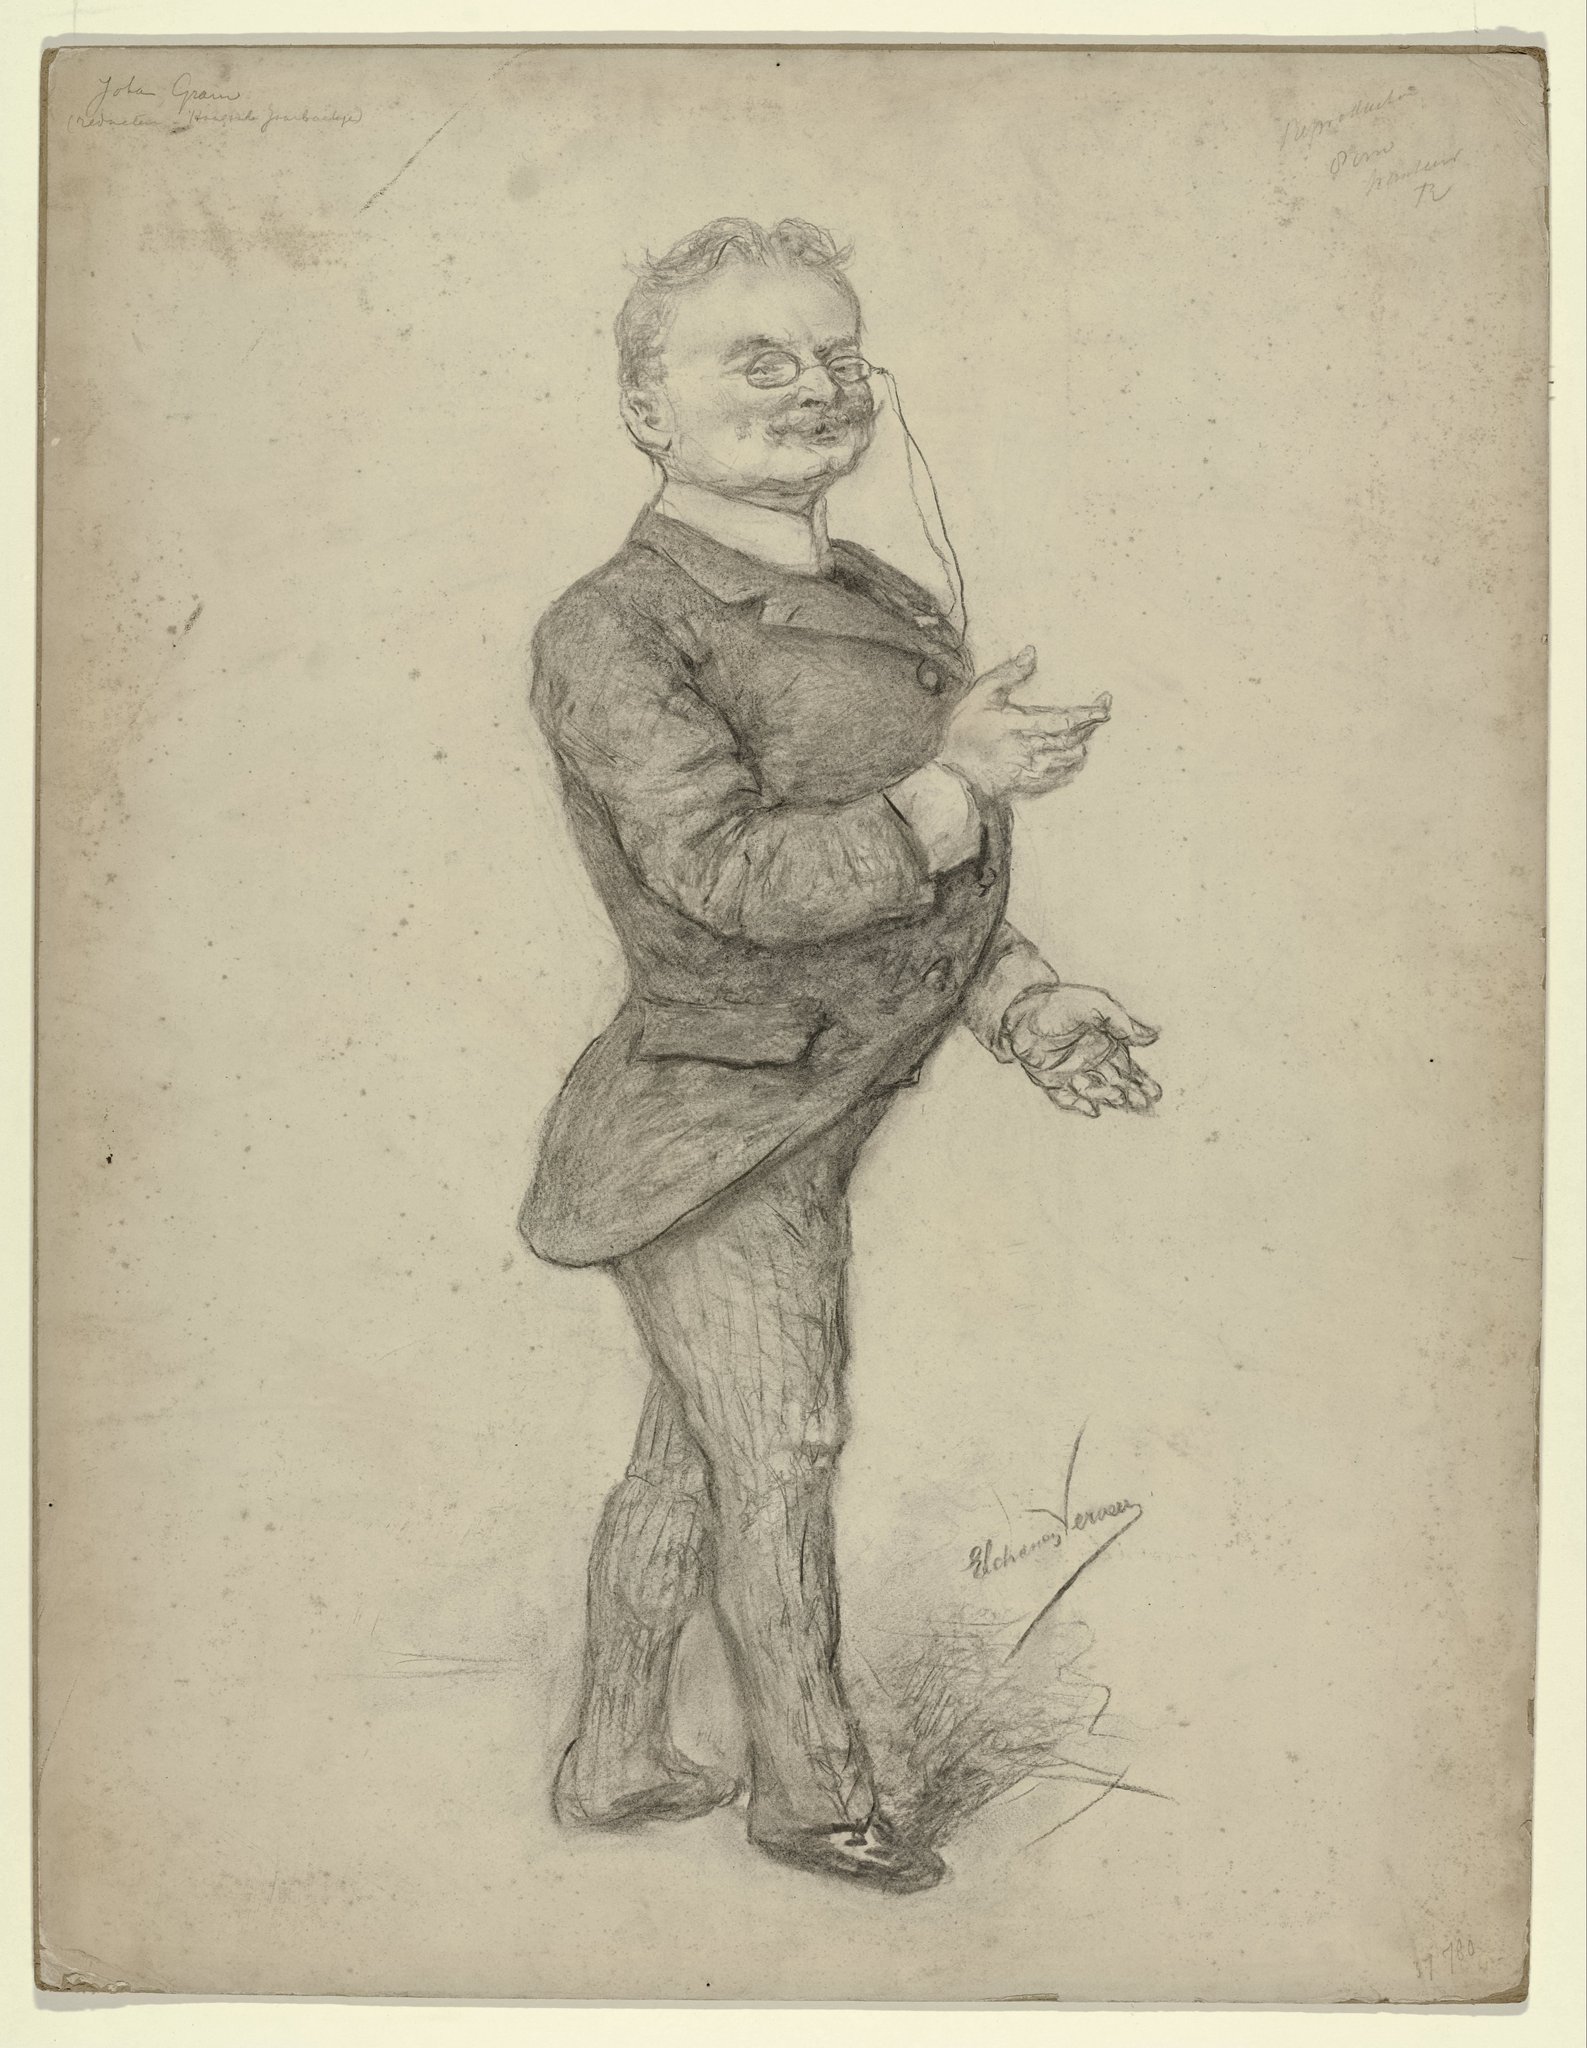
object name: drawing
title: Karikatuurportret van Johan Gram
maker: elchanon verveer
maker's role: draughtsman, print maker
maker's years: 1826-1900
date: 1860-1899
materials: charcoal, paper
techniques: stumping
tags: the hague, johan gram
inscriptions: inscription, signature: ‘Elchanon Verveer’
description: Karikatuurportret van Johan Gram (1833-1913), kunstcriticus, litterator en redacteur Haagsch Jaarboekje.